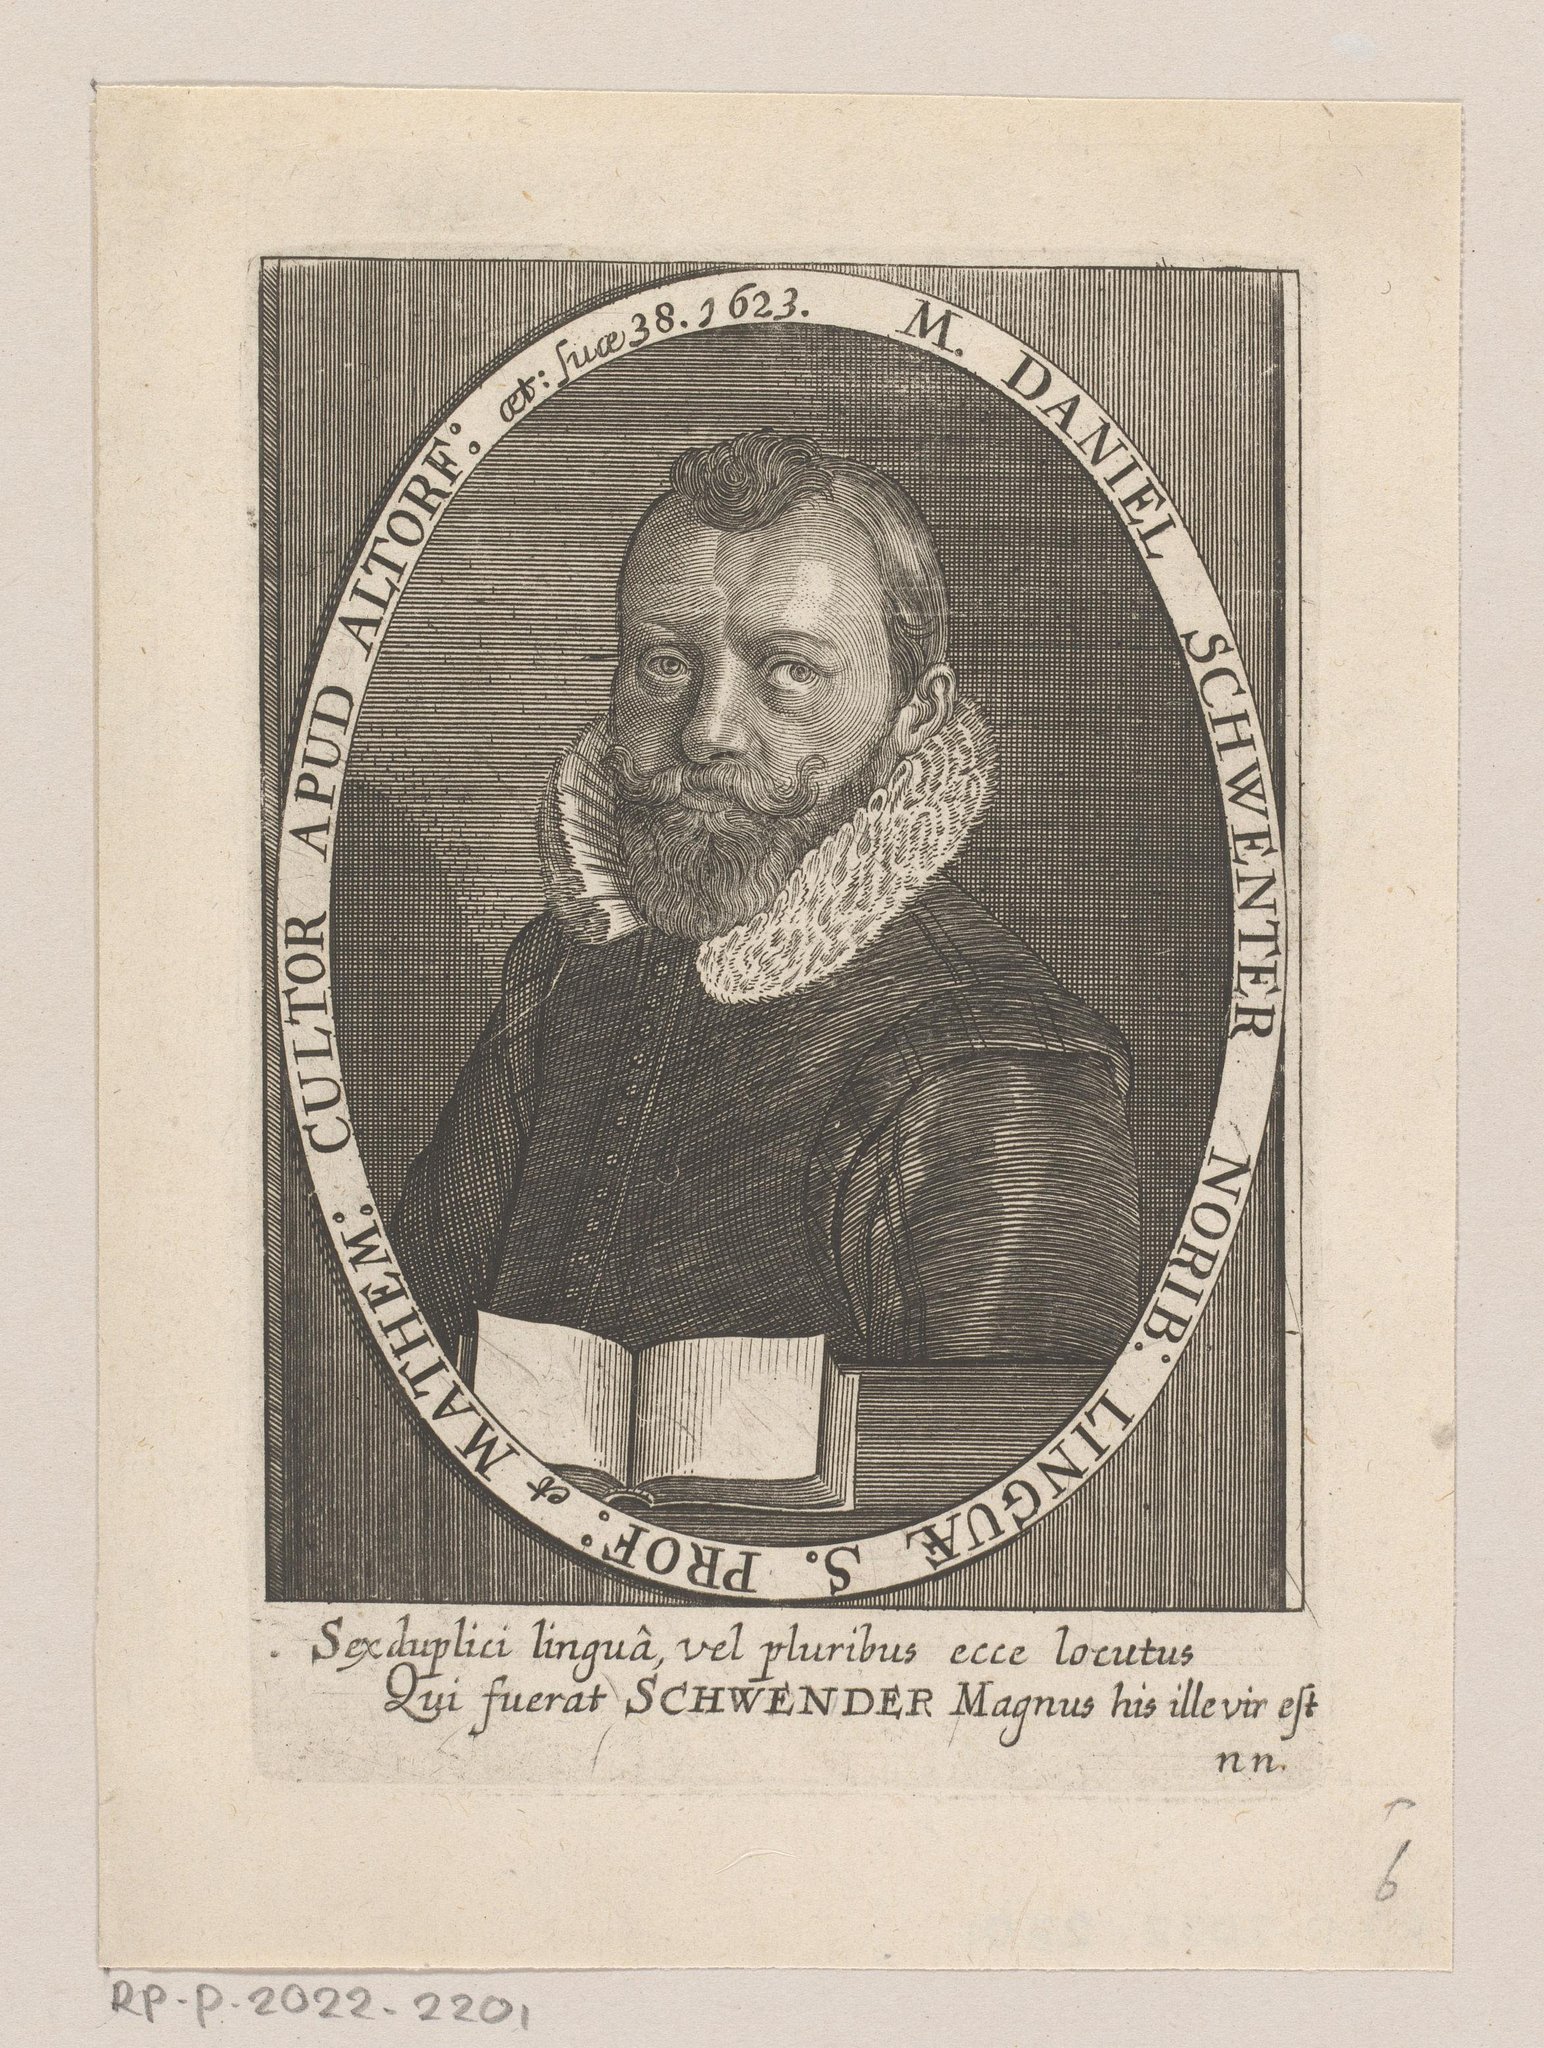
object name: print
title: Portretten van geleerden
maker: Anonymous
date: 1650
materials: paper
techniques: engraving, etching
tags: further education (+ portrait of teacher, professor), ethnology, cultural anthropology (+ portrait of scholar, scientist), historical persons, mathematics (+ portrait of scholar, scientist)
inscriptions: number: ‘6’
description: Prent uit: Boissard, Jean Jacques. Bibliotheca chalcographica (...) VII pars. Frankfurt am Main: Johannes Ammon, 1650.